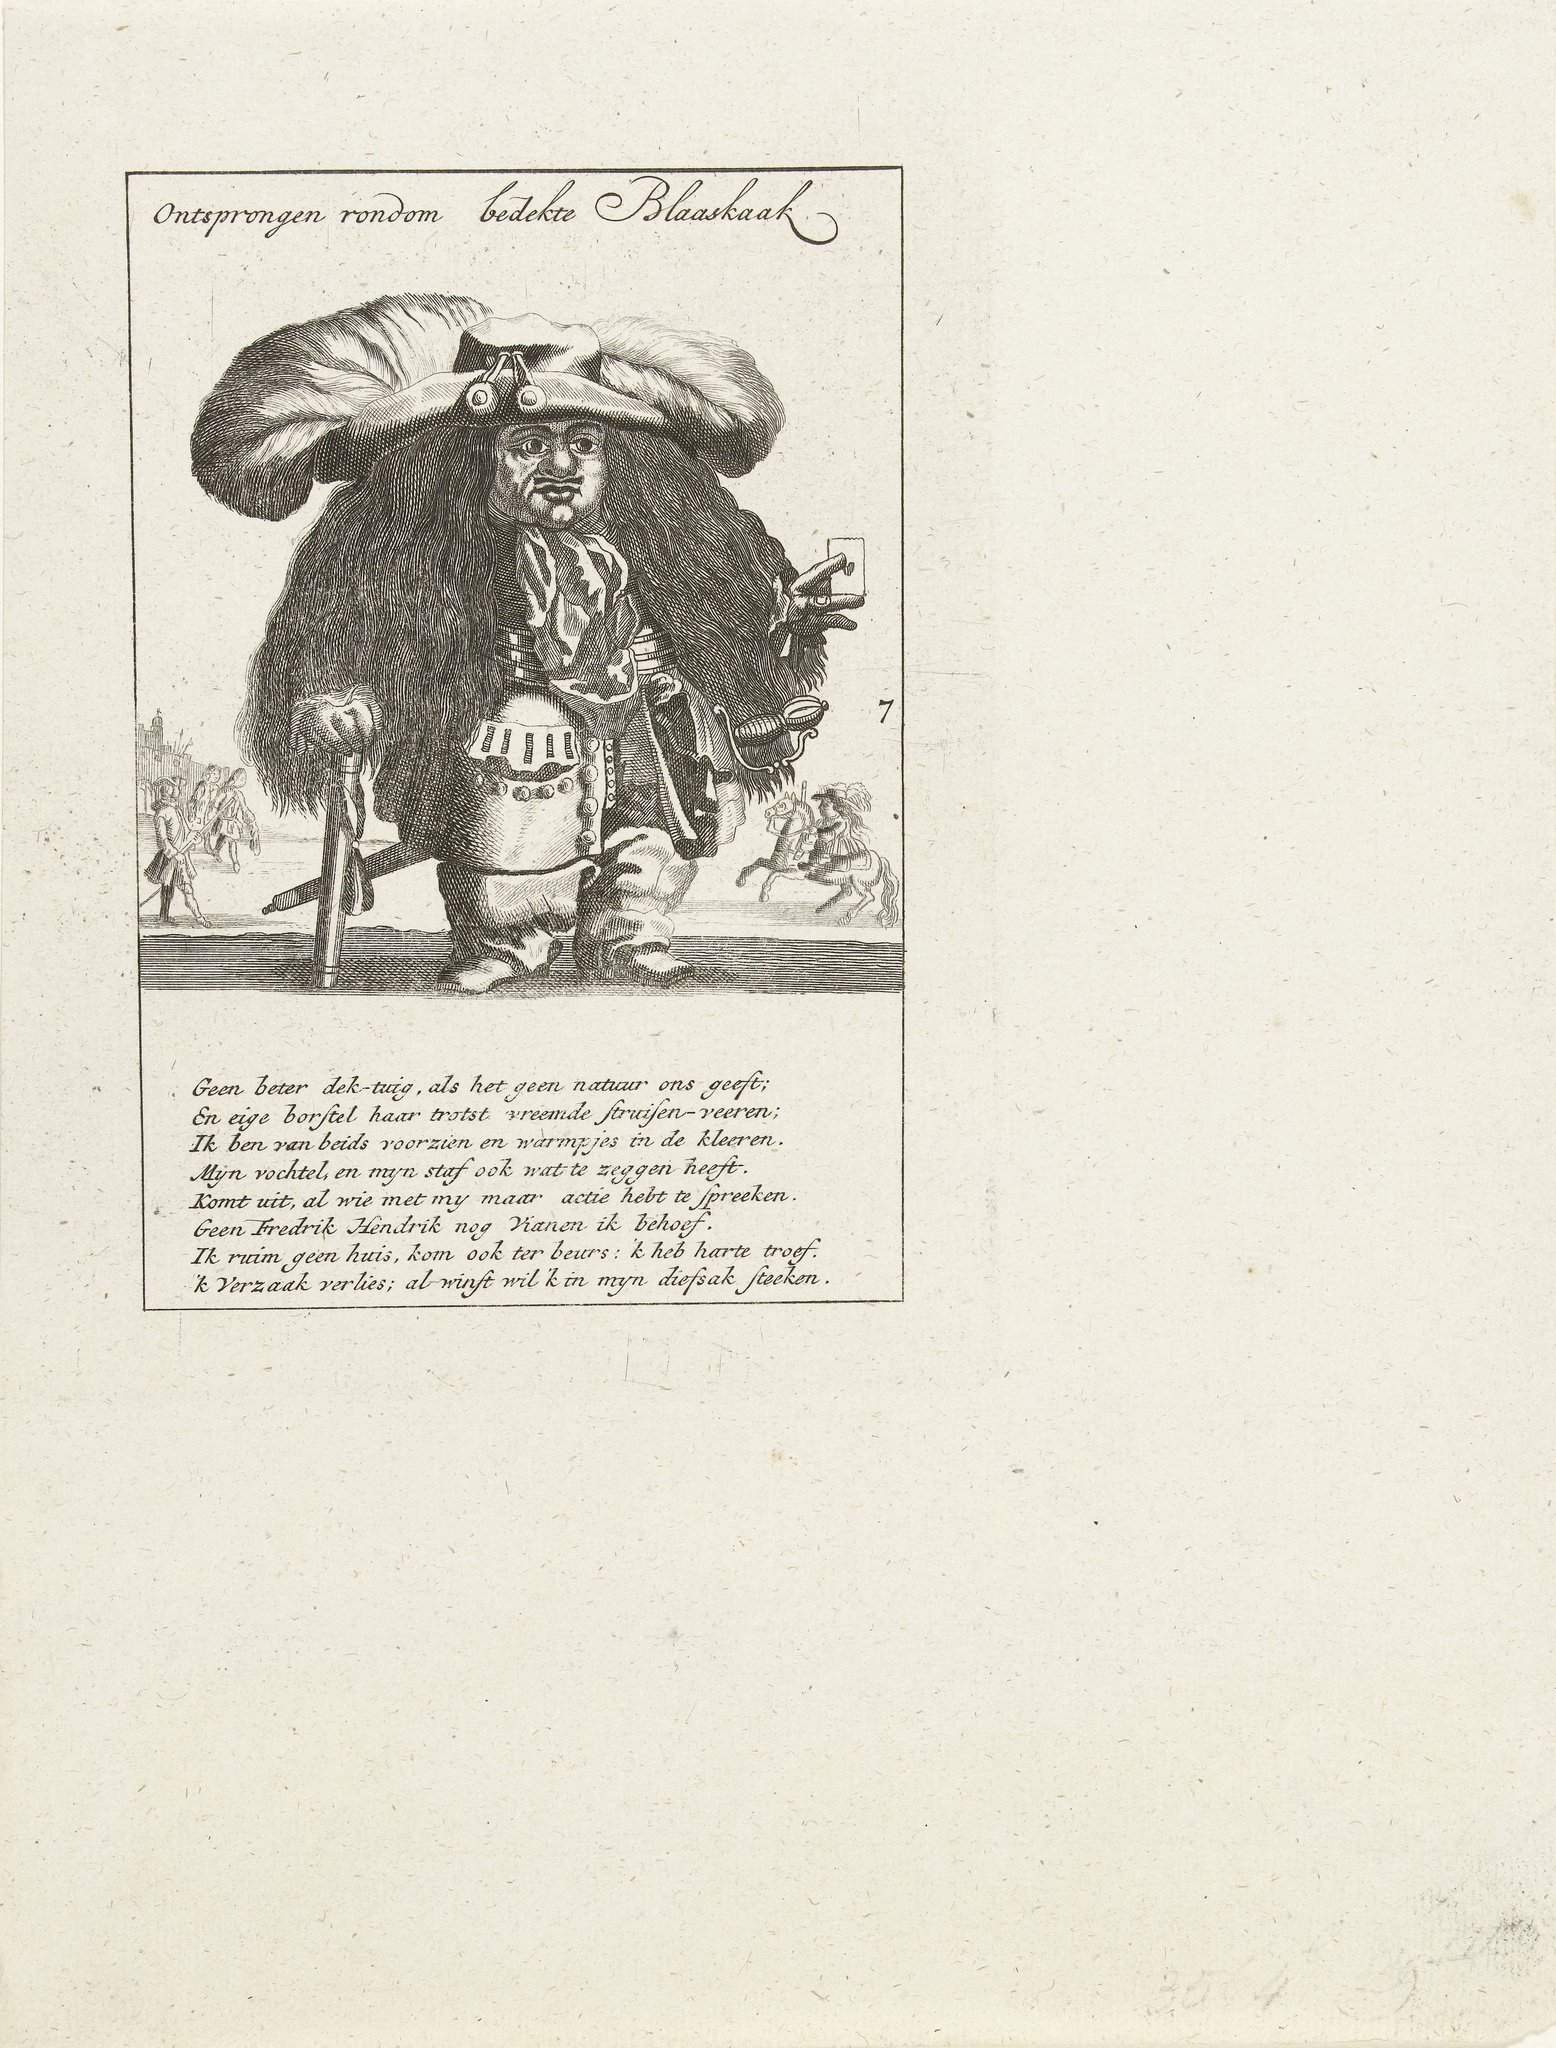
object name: caricature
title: Karikatuur van dwerg en de windhandel, 1720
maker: Anonymous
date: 1770-1780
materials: paper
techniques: etching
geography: northern netherlands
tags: caricatures (human types), little people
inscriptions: collector's mark: Lugt 2228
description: Een kleine mens als een officier met grote verenhoed en een speelkaart in de hand. Karikatuur van figuren in de windhandel, met een verwijzing in het onderschrift naar Vianen. Genummerd 7. Gedrukt van een grote plaat waarop alle vier voorstellingen genummerd 5-8 zijn geëtst. Kopie naar prent 29/7 in de serie Het Groote Tafereel der Dwaasheid met spotprenten op de Windhandel of Actiehandel van 1720.